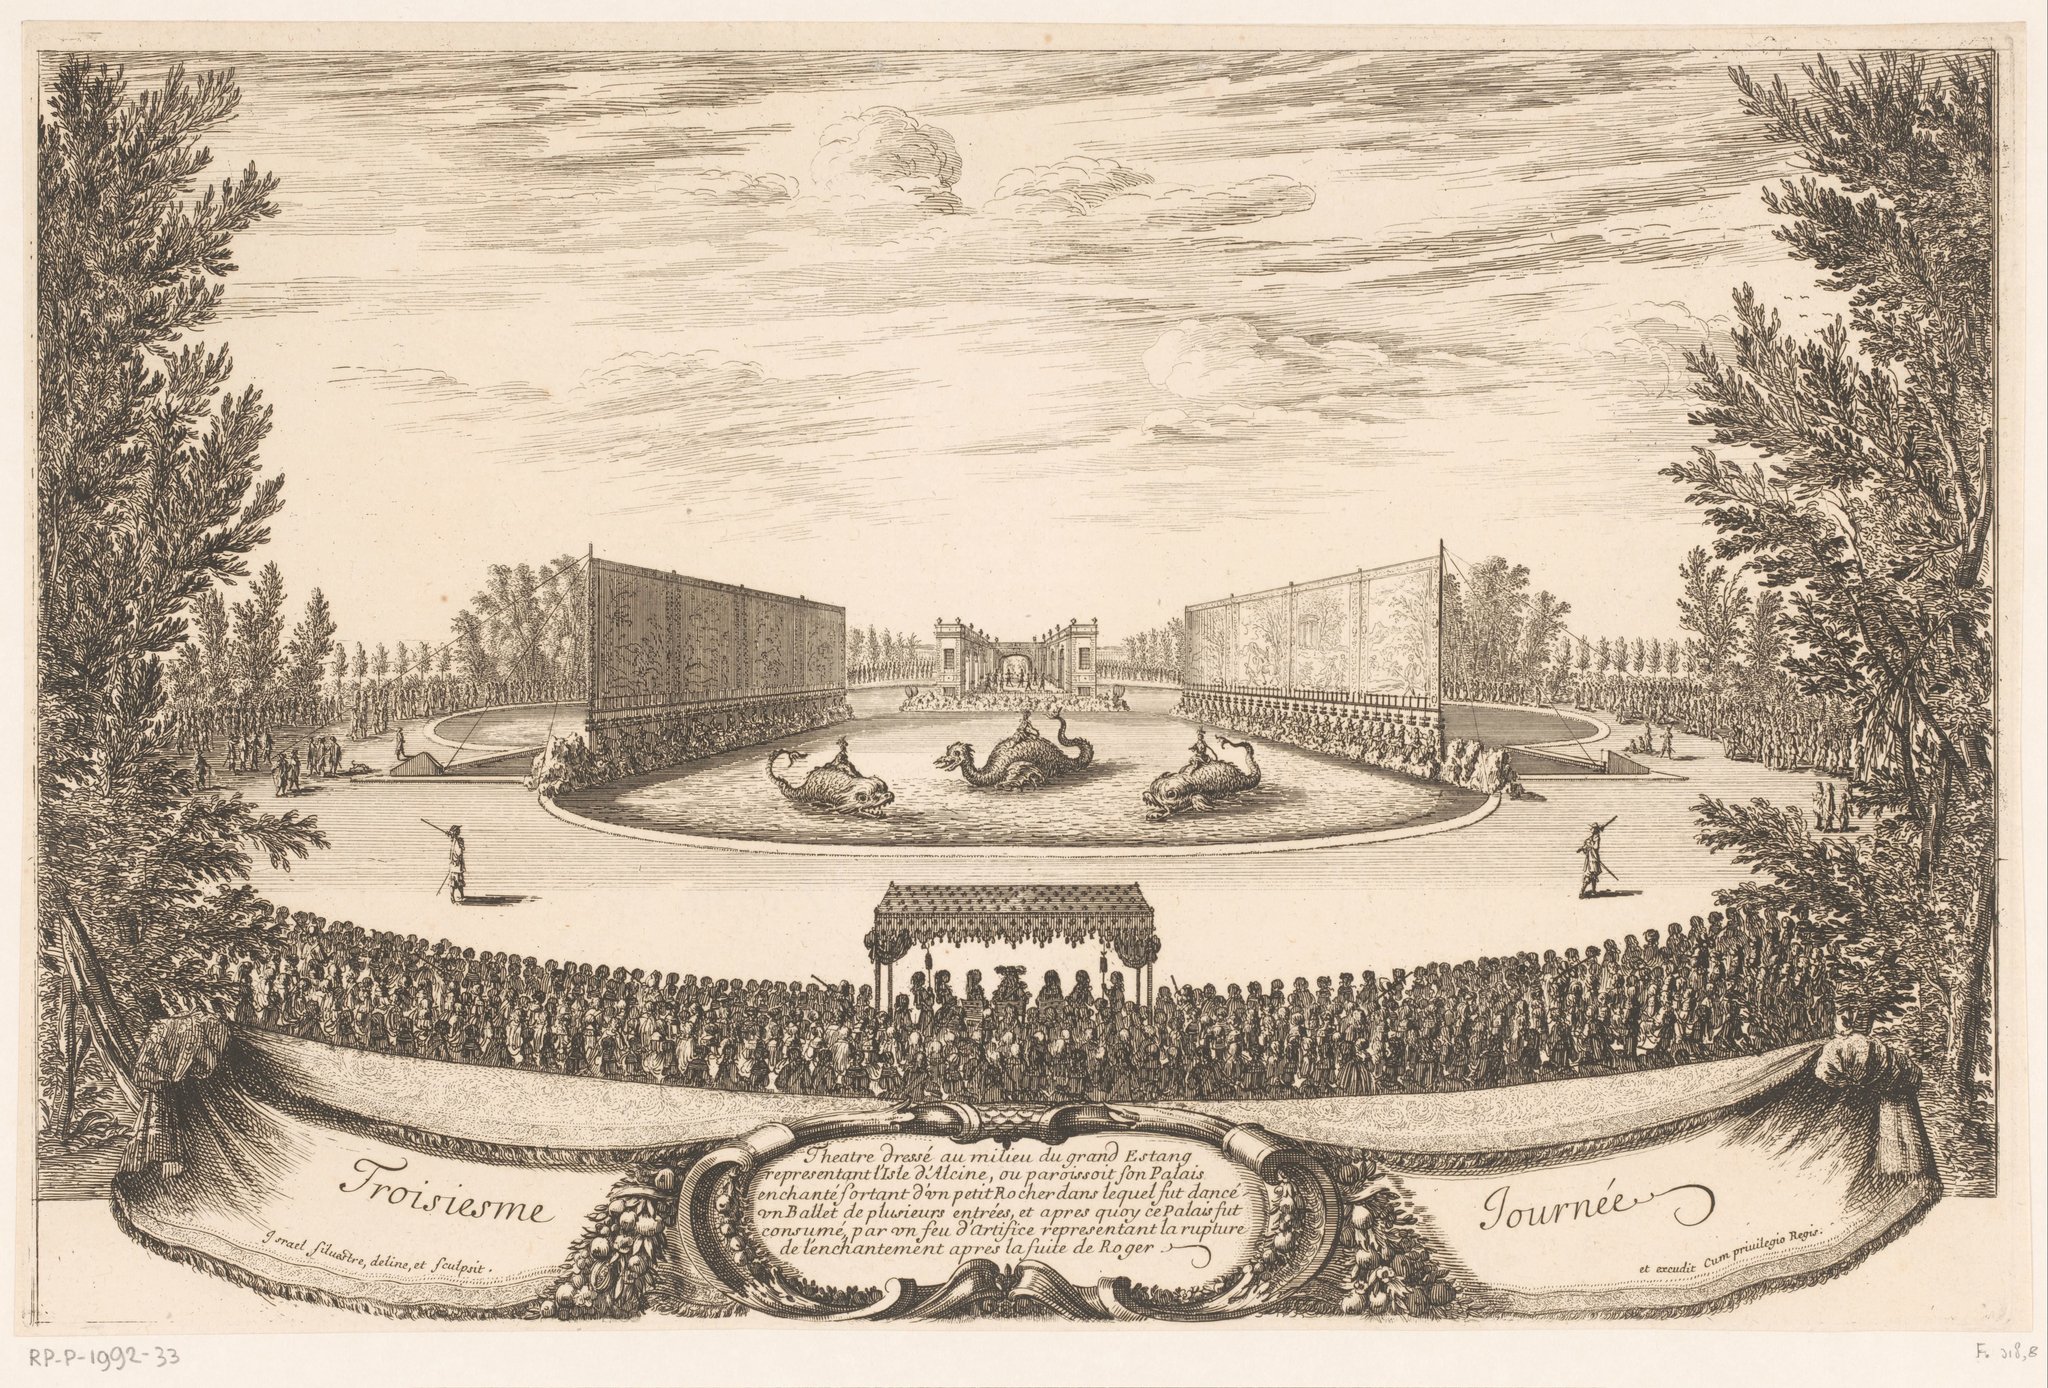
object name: print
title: Les plaisirs de l'isle enchantée, ou les festes, et divertissements du Roy a Versailles (...) 1664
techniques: engraving, etching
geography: france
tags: lodewijk xiv (koning van frankrijk), french or architectonic garden; formal garden, monsters of the sea, festivities, king, monsters ~ swimming mammals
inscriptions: collector's mark: Lugt 2760, collector's mark: Lugt 2228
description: In de grote vijver van de tuin van Versailles is een theater opgericht dat het eiland van Alcine voorstelt met een klein kasteel waarin een ballet wordt opgevoerd. Het koninklijk gezelschap zit, op de voorgrond op de rug gezien, naar het schouwspel te kijken. In de vijver, voor het eiland, drijven drie watermonsters. Onder de voorstelling een draperie met de titel.